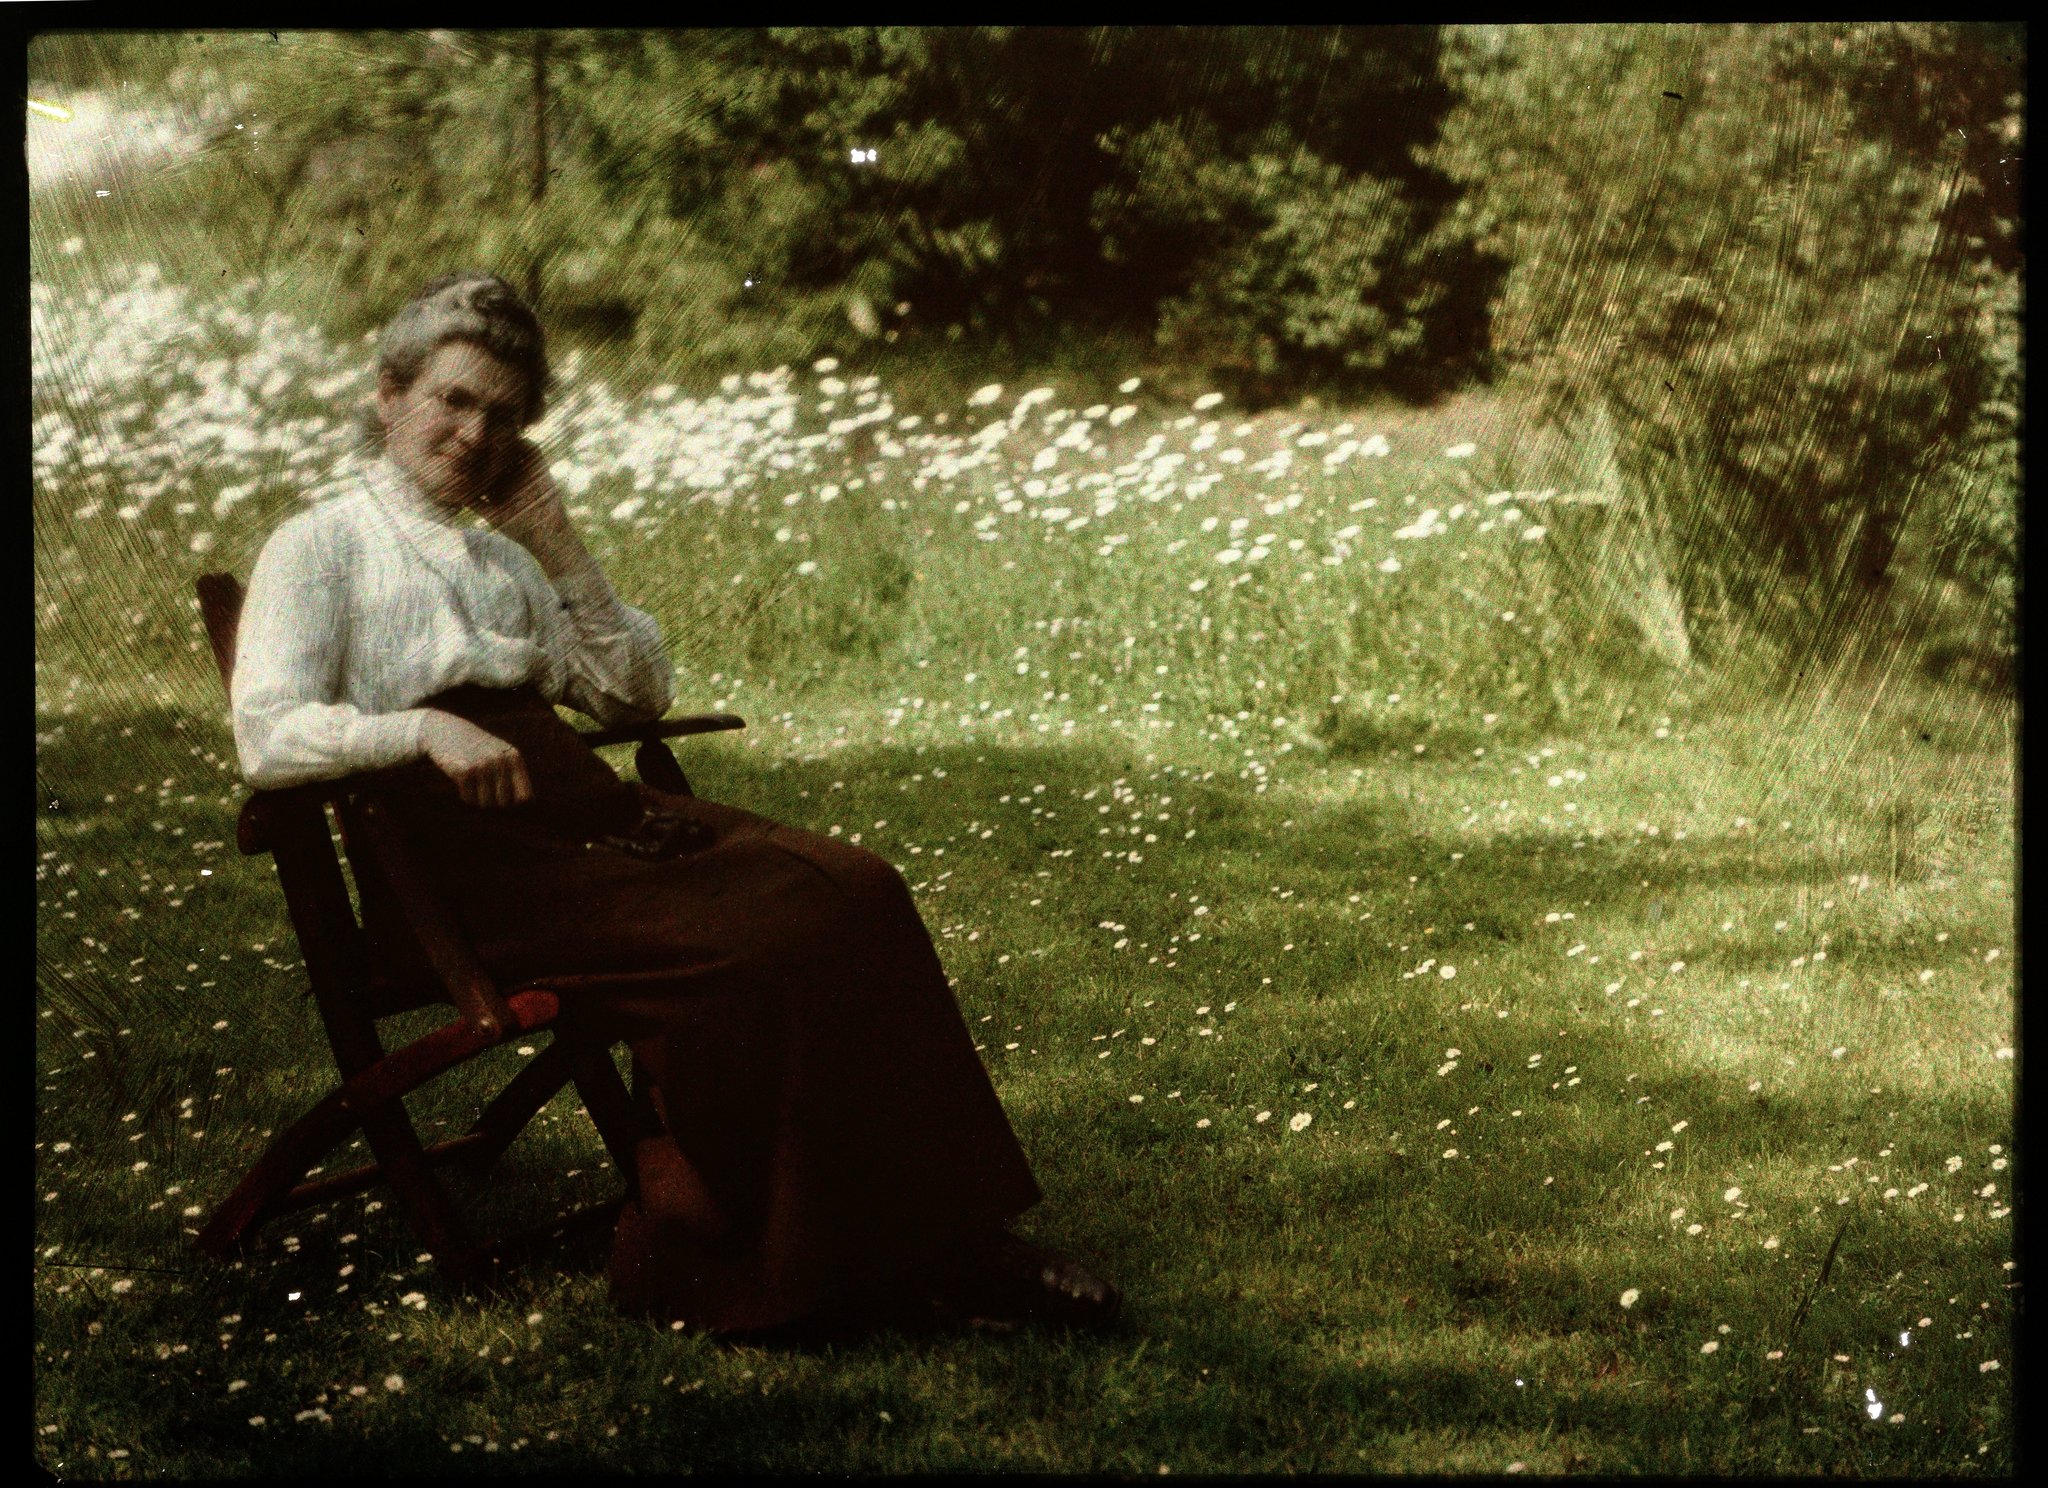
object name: color slide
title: Oude vrouw (gekleed in een witte blouse en een donkere rok) zittend in een stoel op een grasveld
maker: adolphe burdet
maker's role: fotograaf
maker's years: 1860-1940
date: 1907-1930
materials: glass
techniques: autochrome process, slide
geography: netherlands